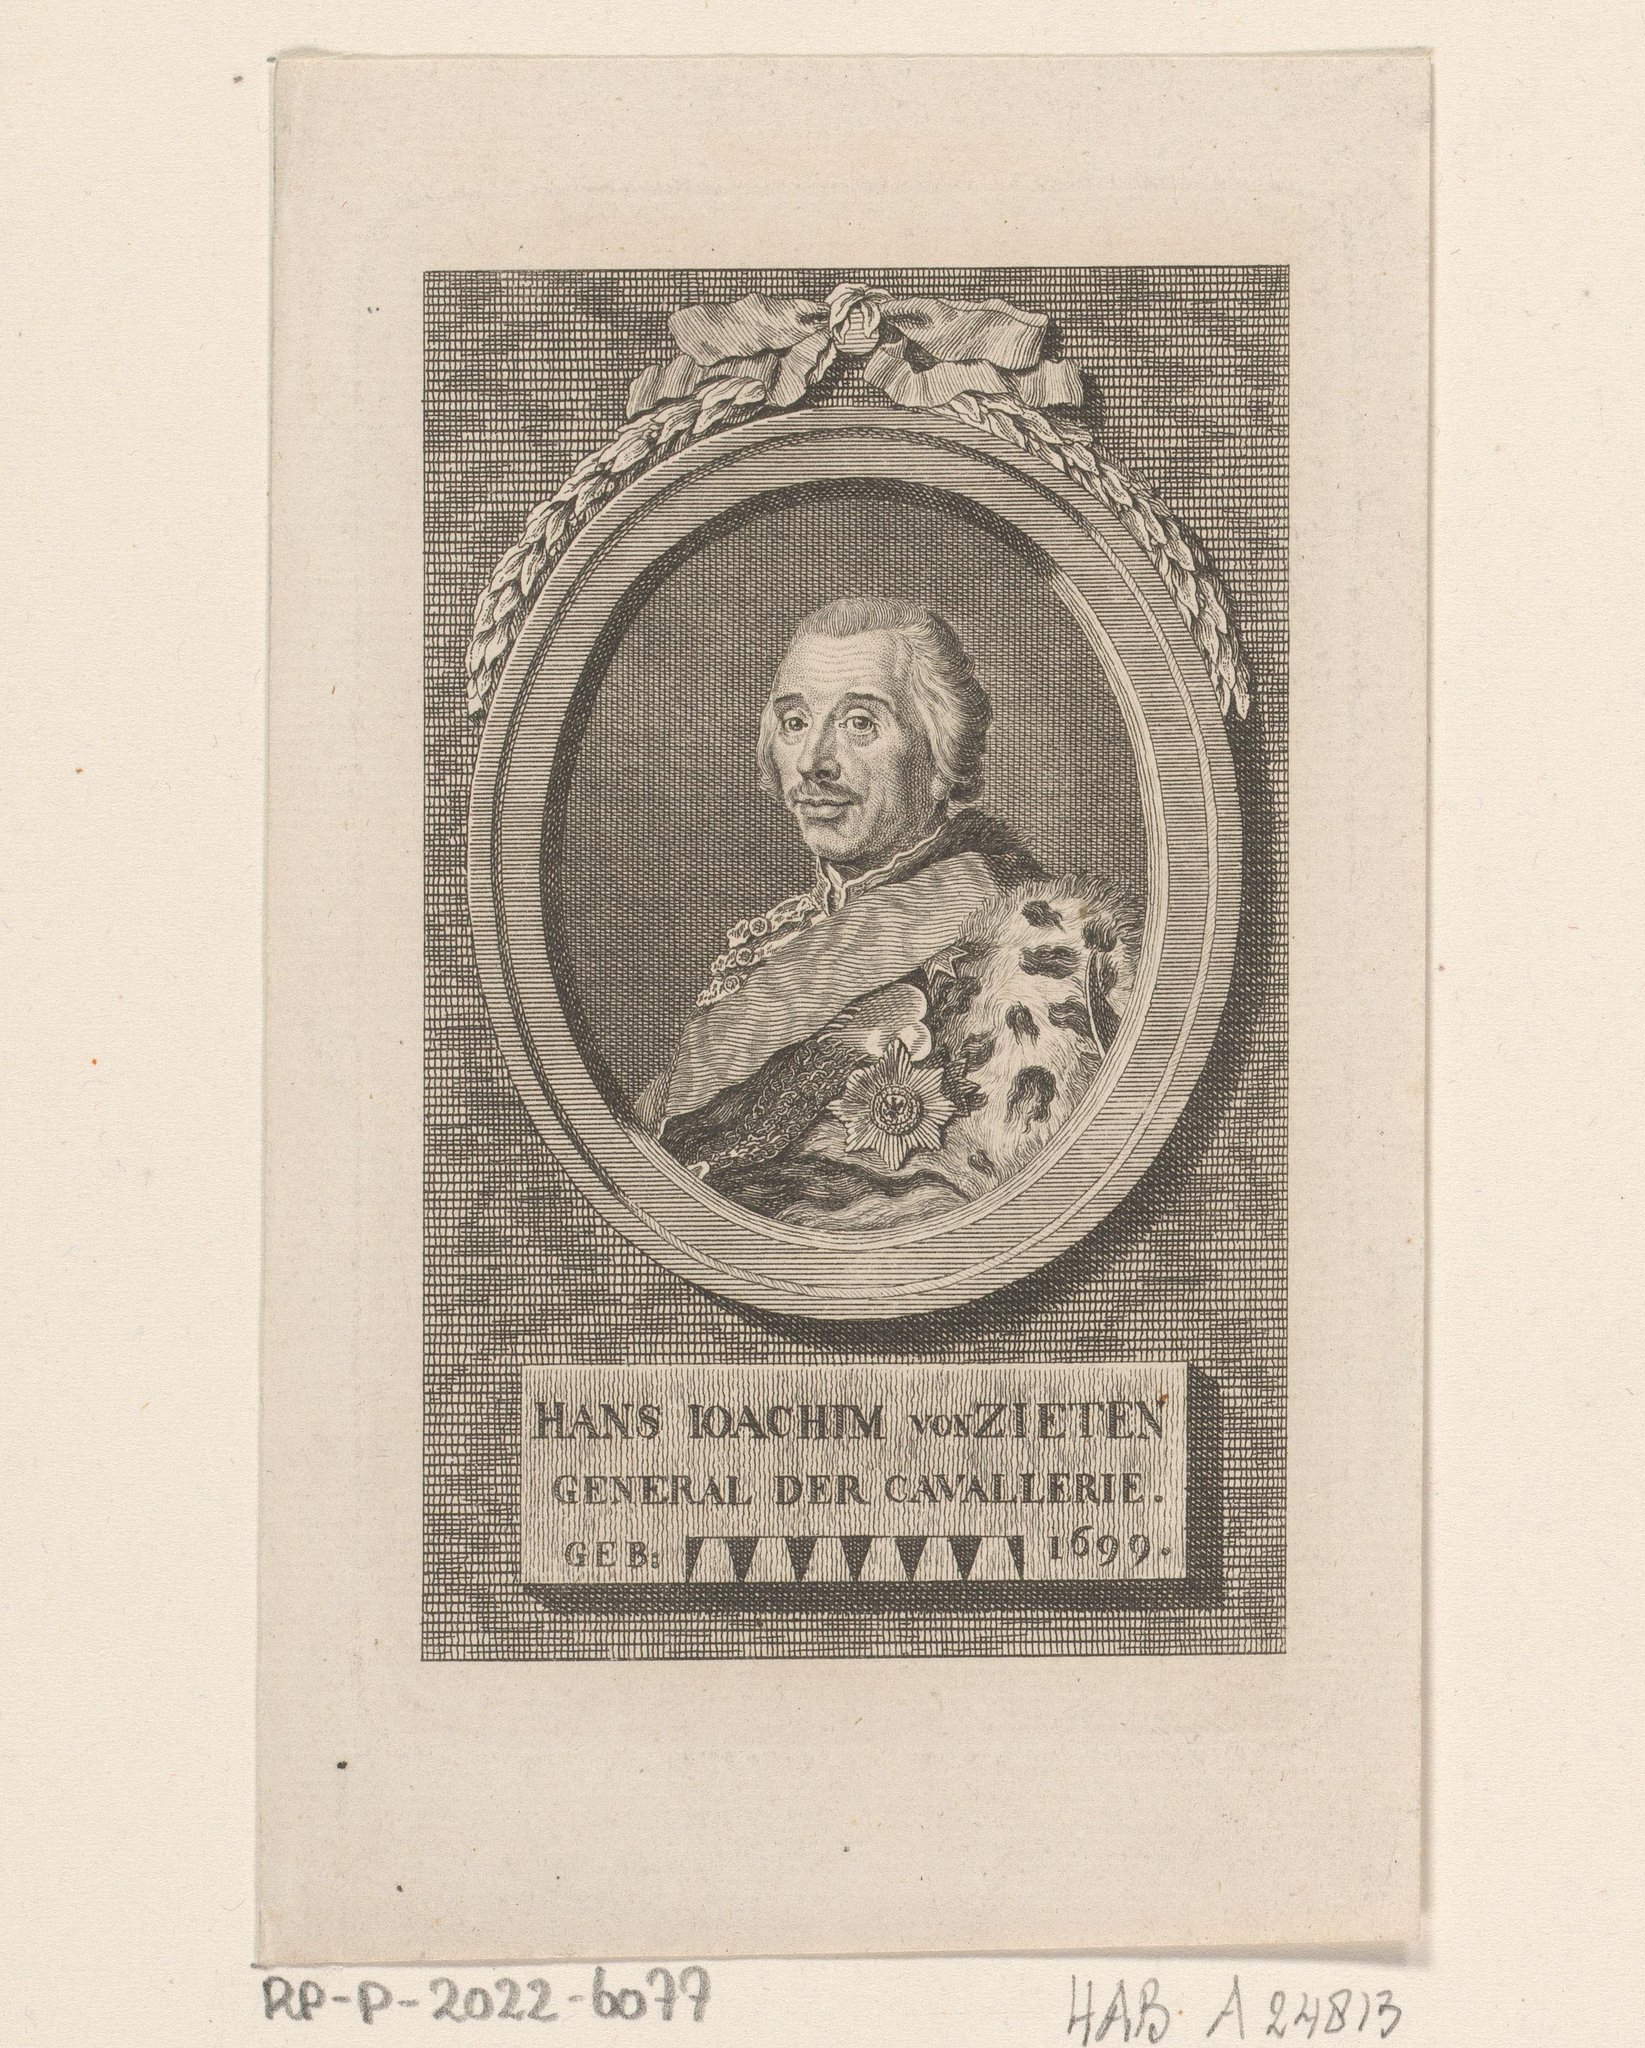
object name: print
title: Portret van Hans Joachim von Zieten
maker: Anonymous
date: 1745-1799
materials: paper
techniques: etching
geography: germany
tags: commander-in-chief, general, marshal, historical persons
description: Met tweeregelig onderschrift in het Duits.